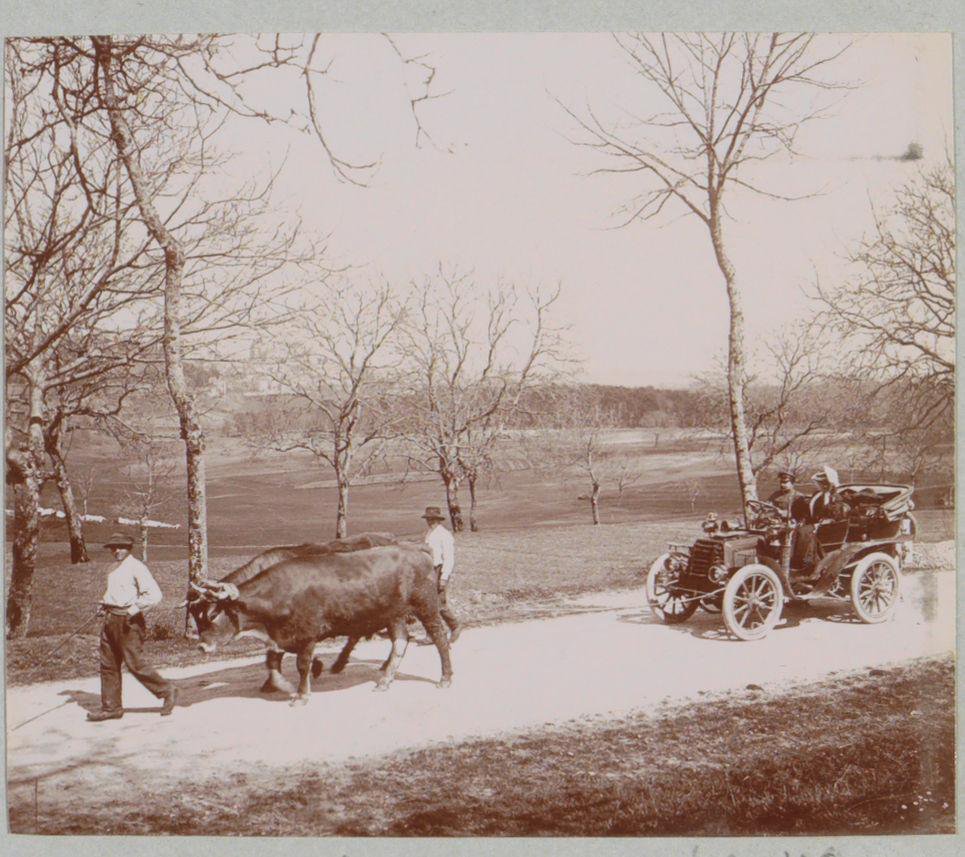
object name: photograph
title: Automobiel rijdt achter ossen aan op een landweg bij Hautefort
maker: delizy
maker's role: manufacturer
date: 1904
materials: paper, photographic support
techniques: gelatin silver print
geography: hautefort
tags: road, path, ox, automobile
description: Onderdeel van Fotoalbum van een Franse amateurfotograaf met opnames van uitstapjes in Frankrijk, Spanje, België, Luxemburg en Nederland, de eerste automobielen en autoraces.